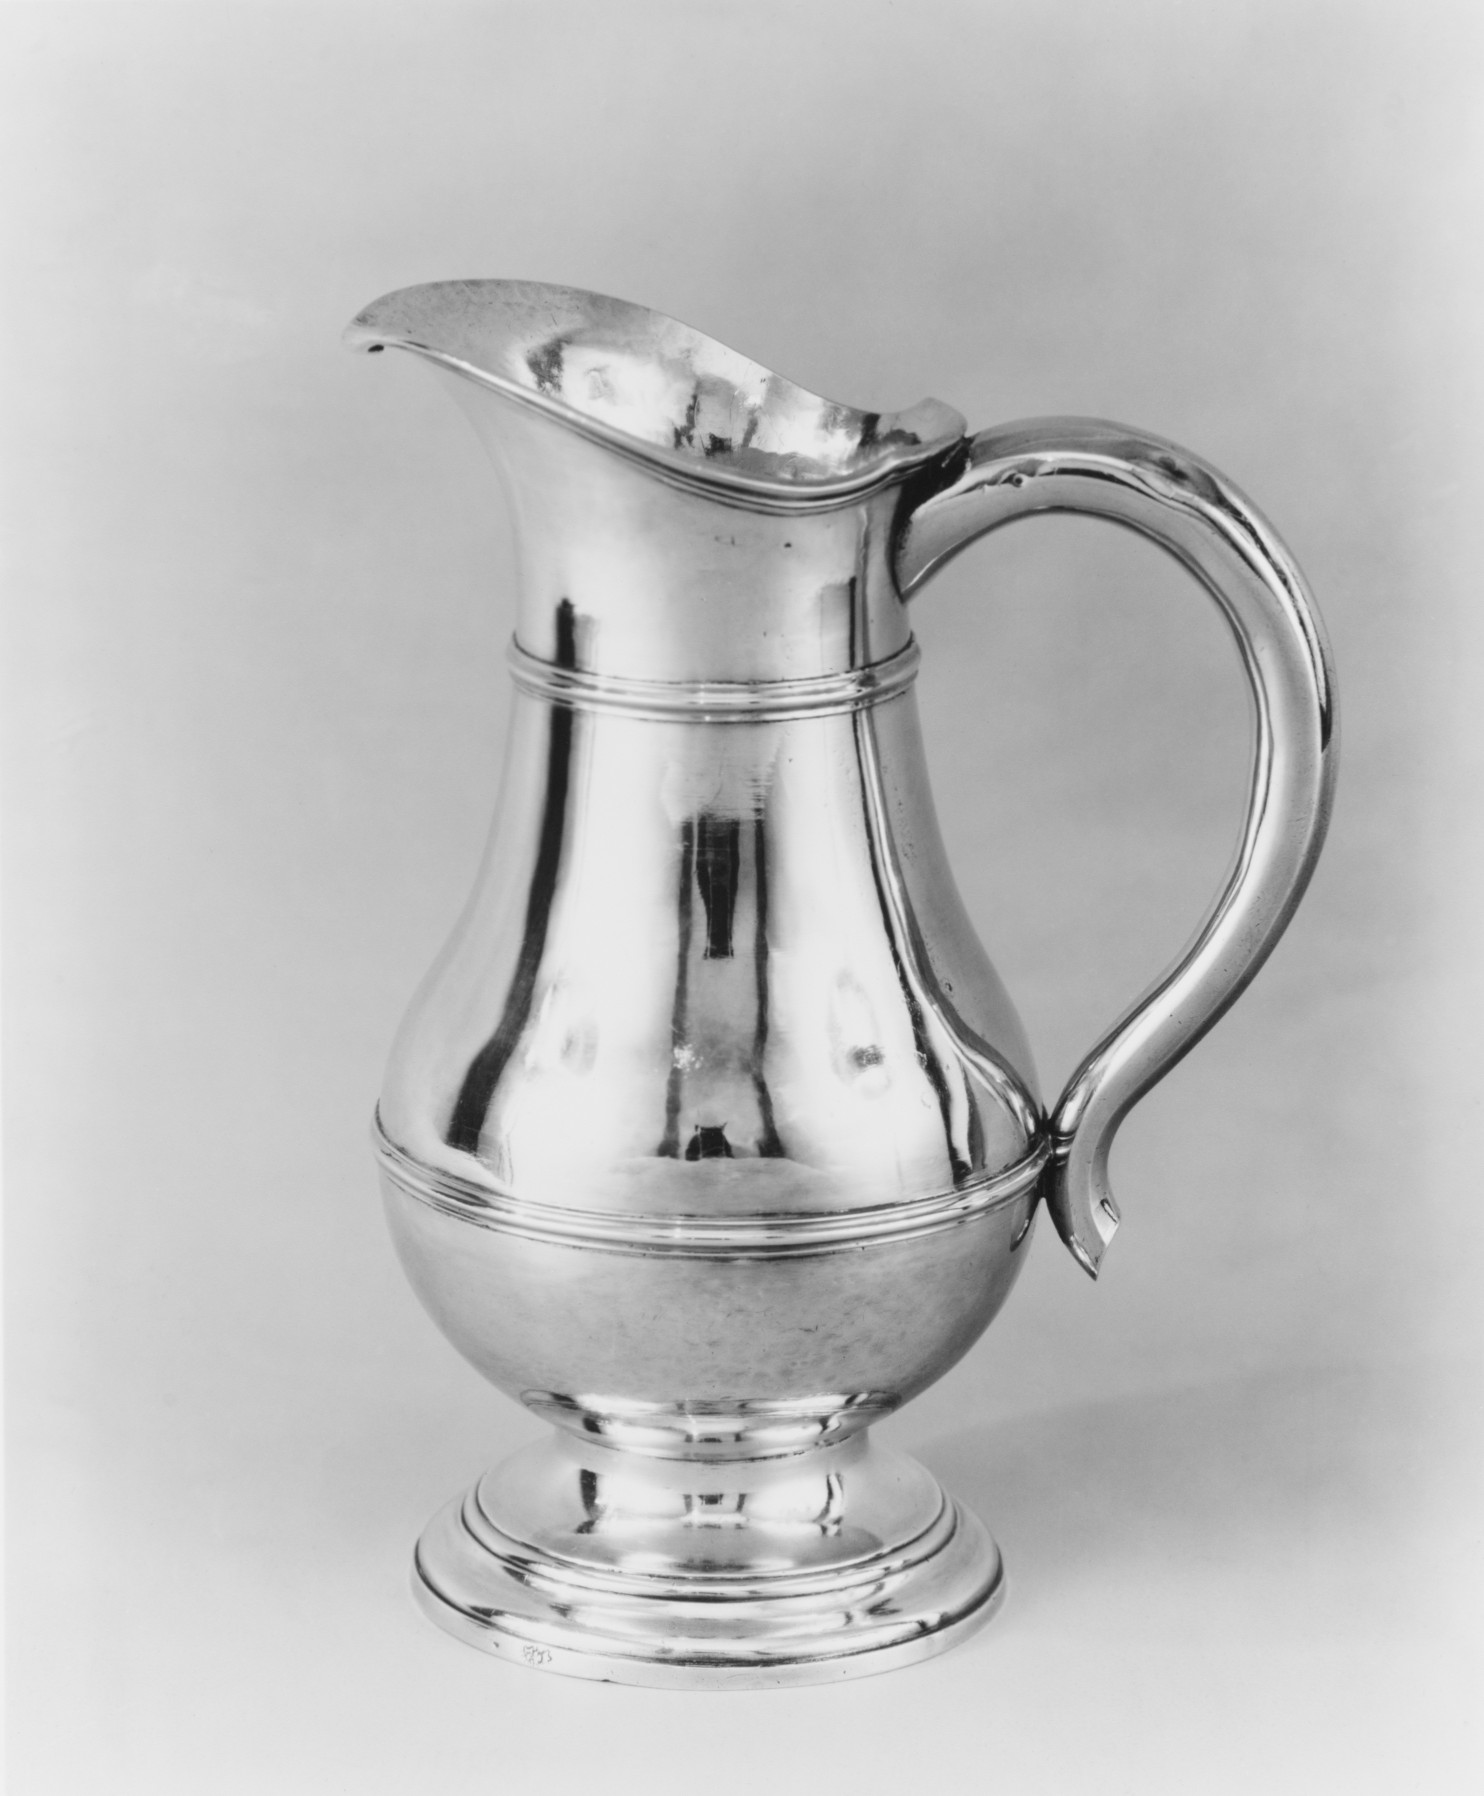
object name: ewer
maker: jean tugot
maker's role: maker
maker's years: 1683-1780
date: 1744-1746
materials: silver